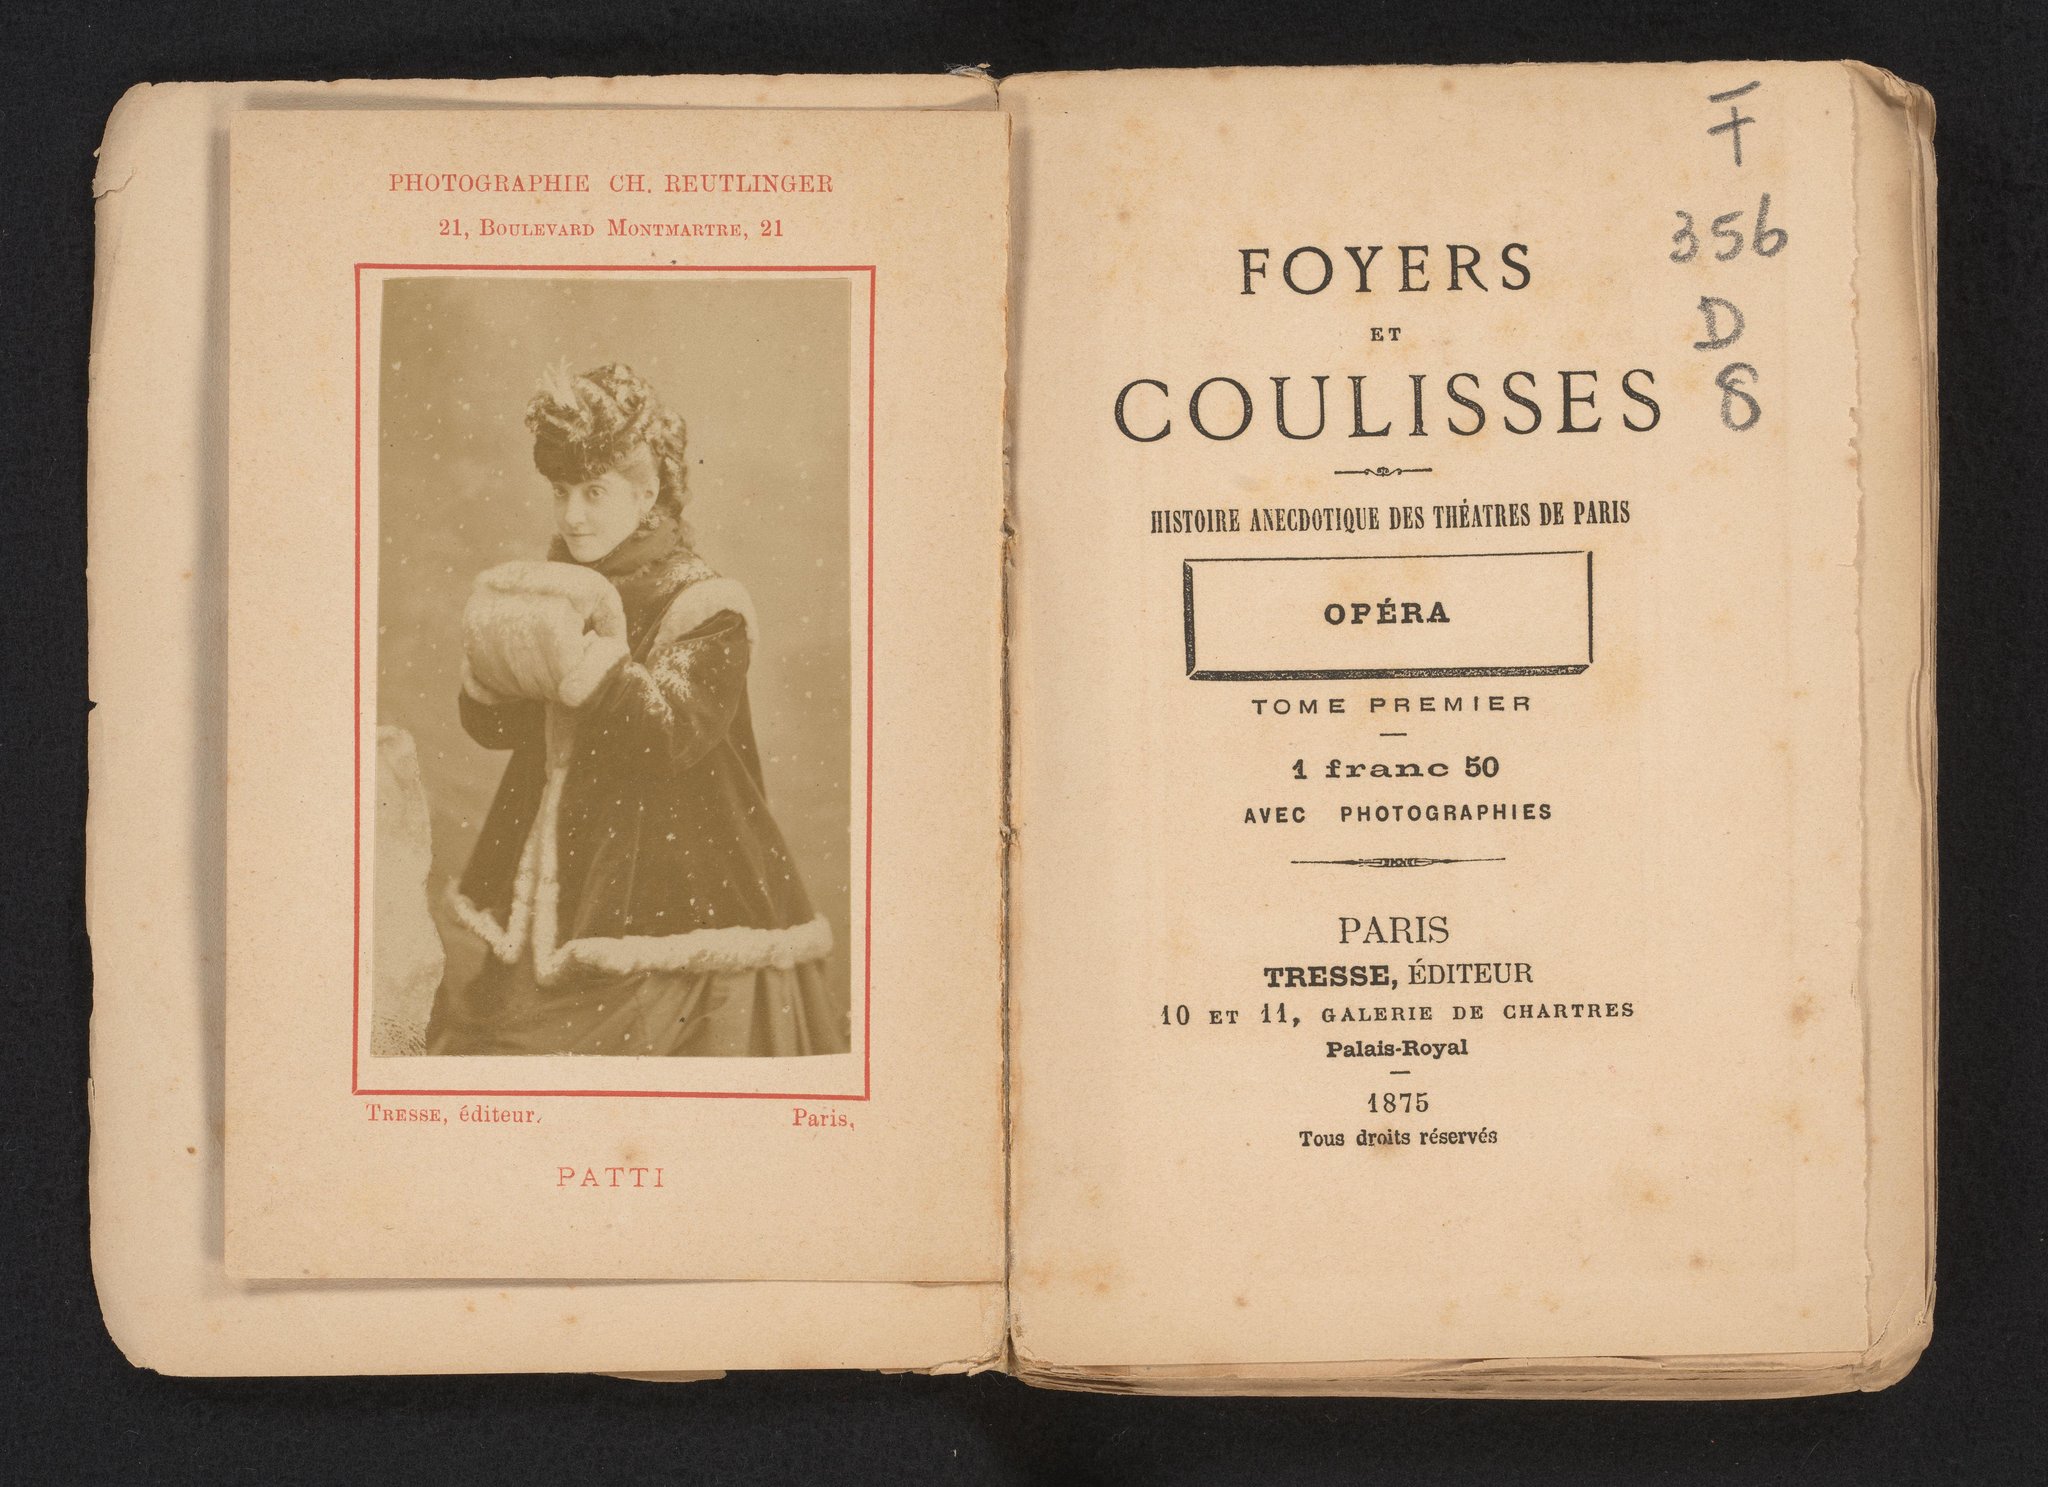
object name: book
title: Foyers et coulisses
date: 1875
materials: paper, photographic support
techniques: albumen print, printing